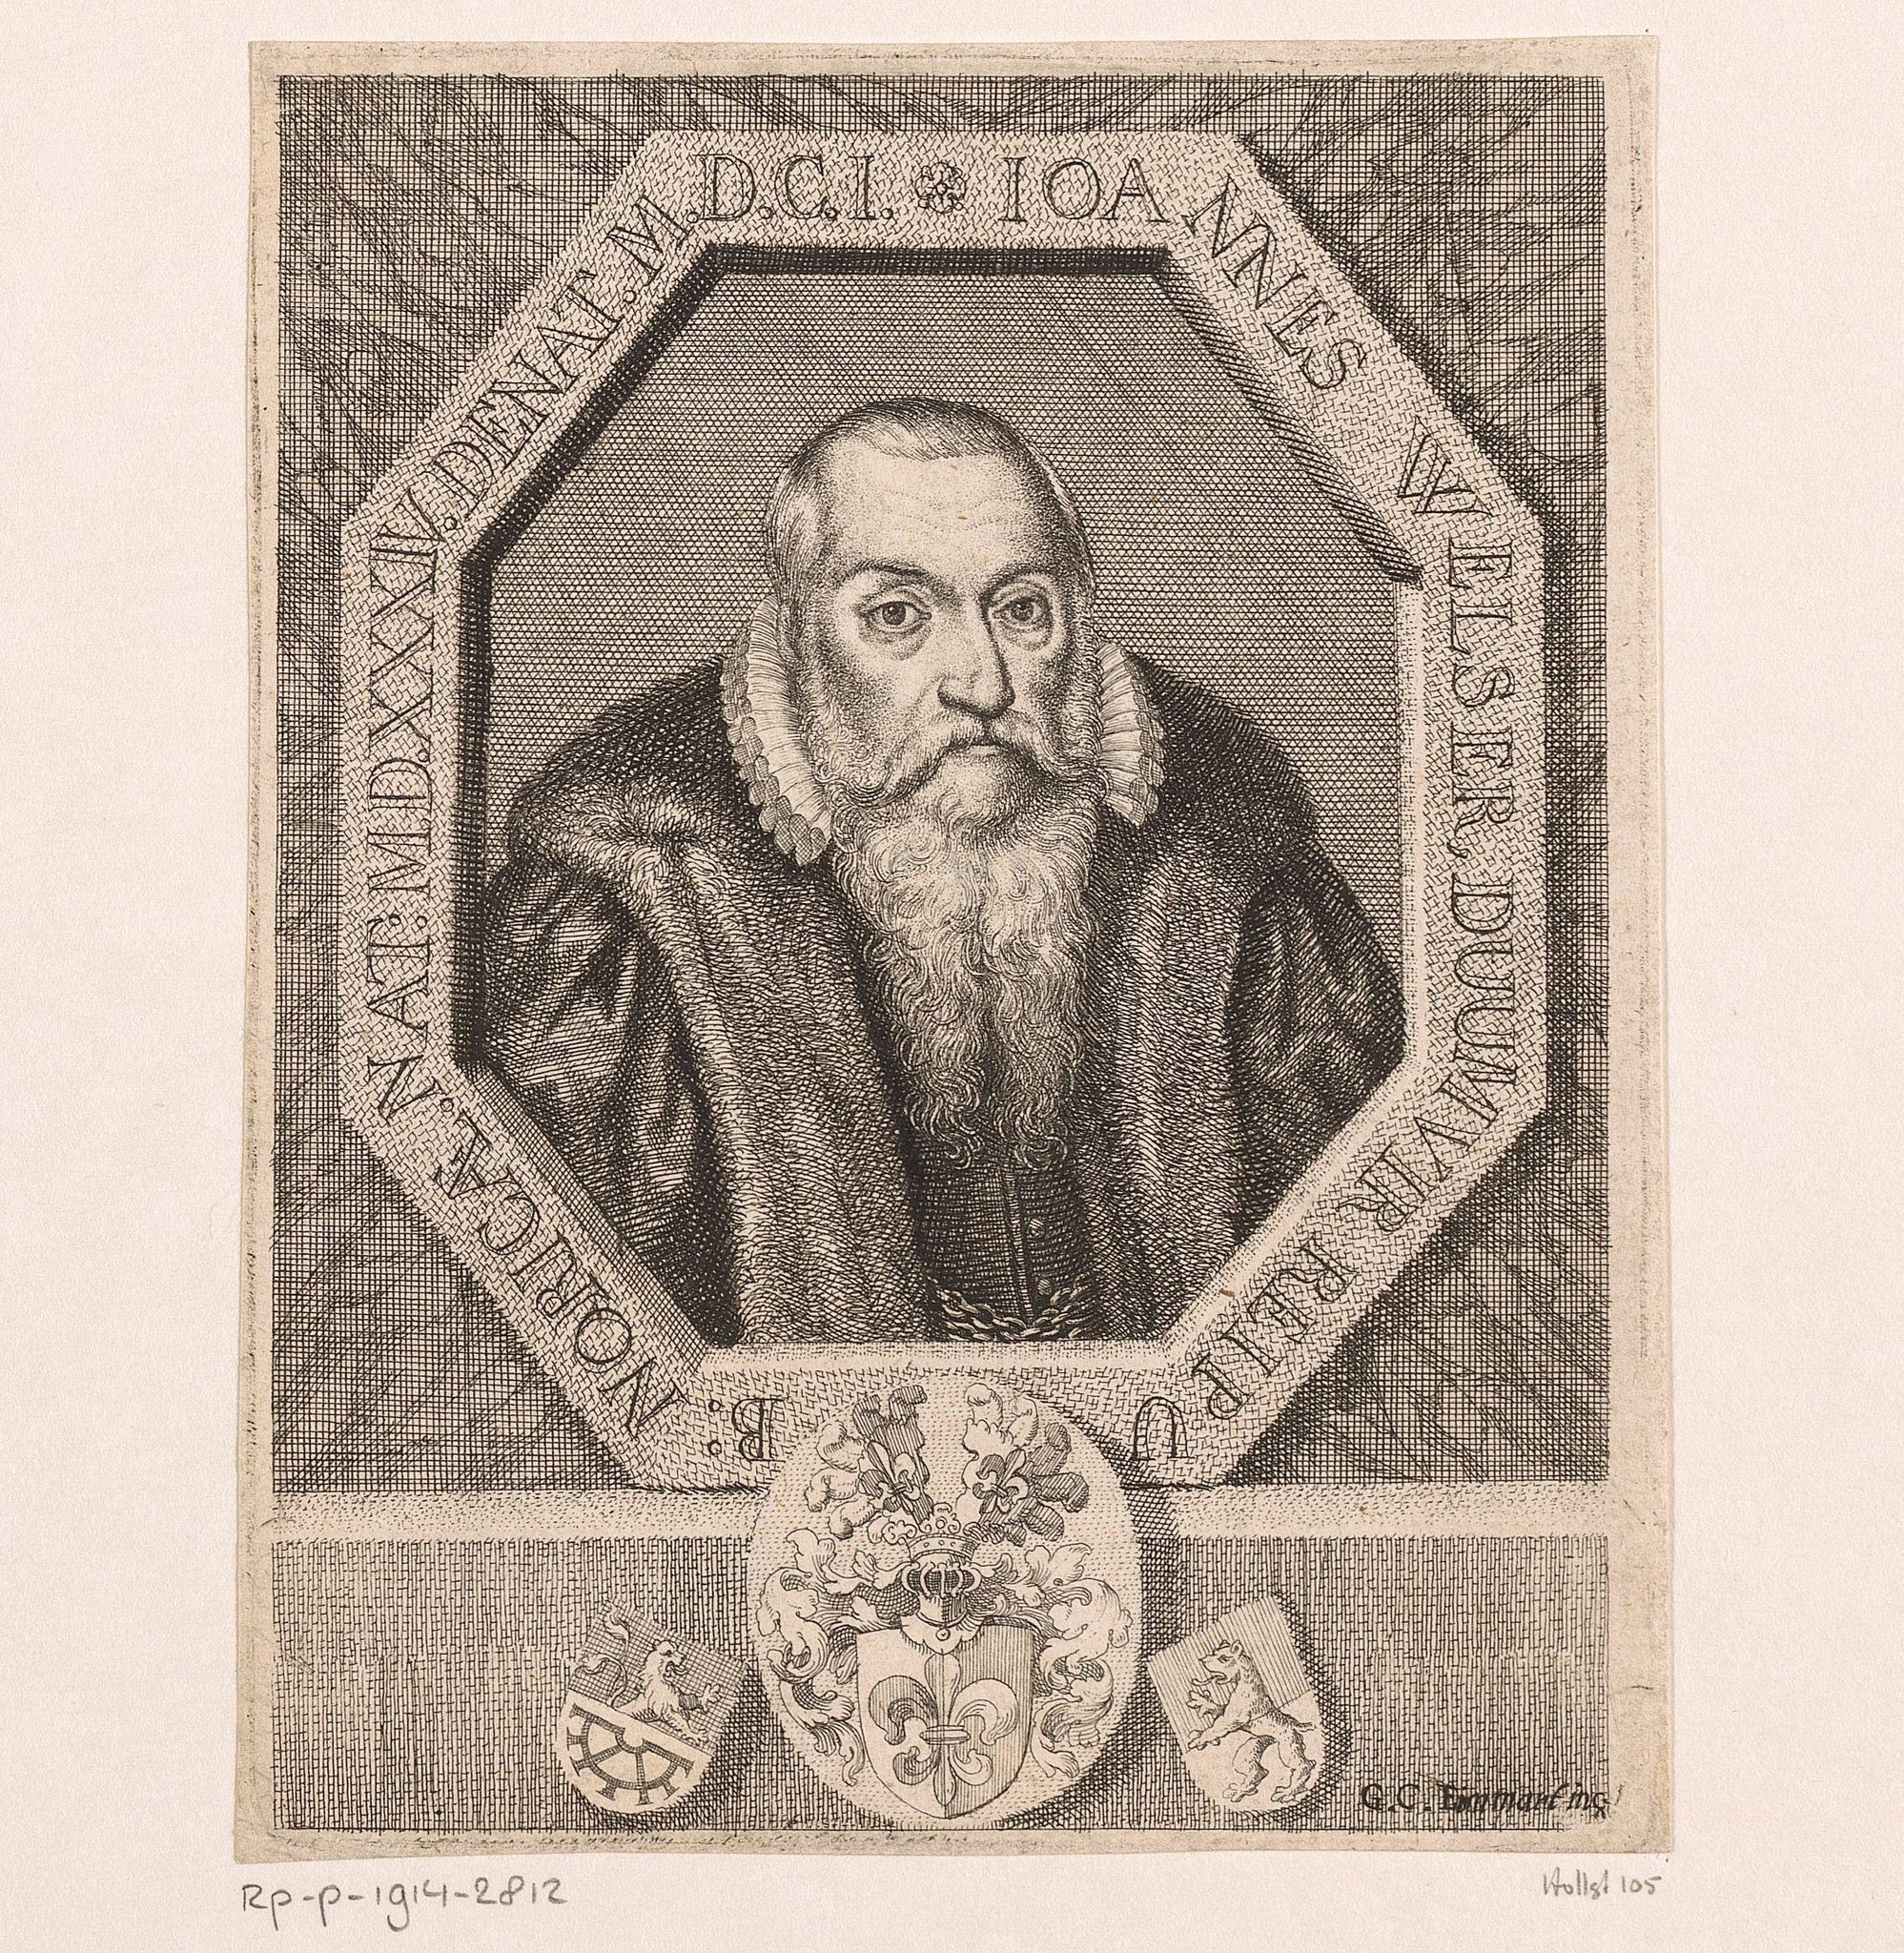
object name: print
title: Portret van Johann Welser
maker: georg christoph eimmart (ii)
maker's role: print maker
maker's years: 1638-1705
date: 1648-1705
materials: paper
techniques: etching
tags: politician, historical persons, armorial bearing, heraldry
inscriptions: collector's mark: Lugt 2228